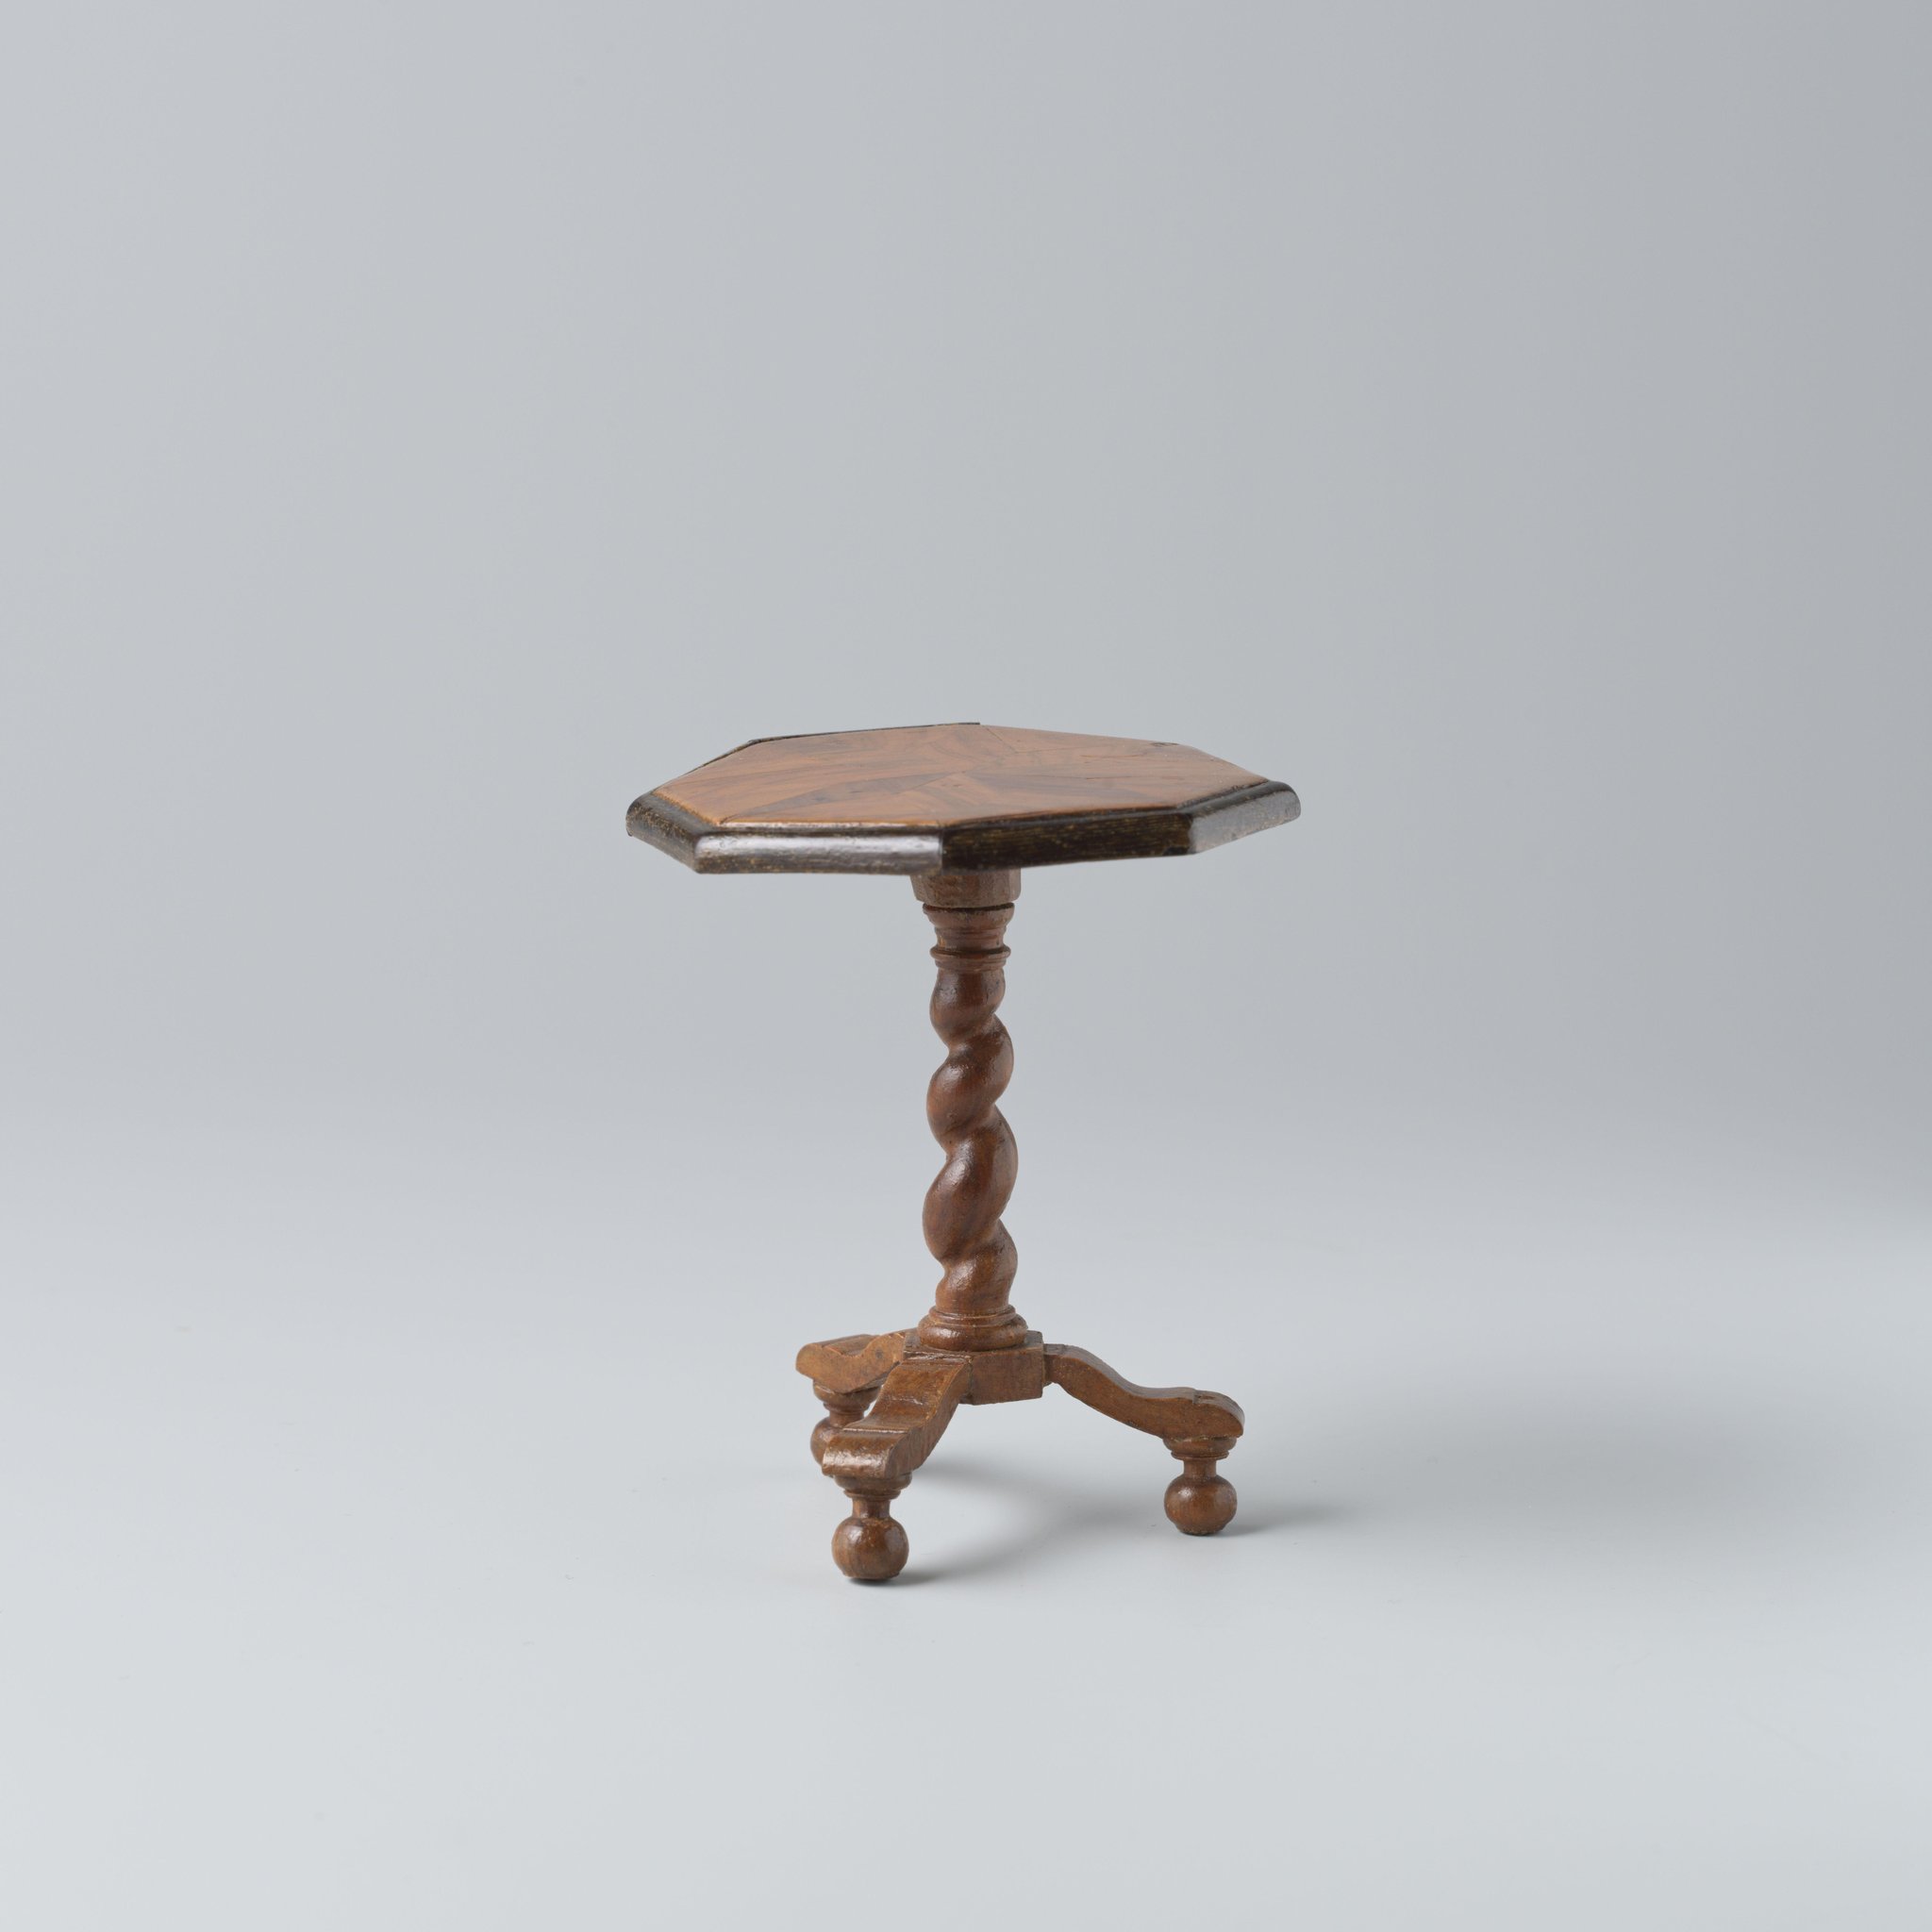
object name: miniature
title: Gueridon met achthoekig blad met sterpatroon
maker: Anonymous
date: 1676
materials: wood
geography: amsterdam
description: Gueridon met achthoekig blad, belijmd met olijfhout in een sterpatroon op een kern van eikenhout. De rand afgezet met ebbenhout. Het blad rust op een getorste poot van olijfhout, op een voet bestaande uit drie straalsgewijs geplaatste, licht gebogen steunen, rustend op drie bolpoten.